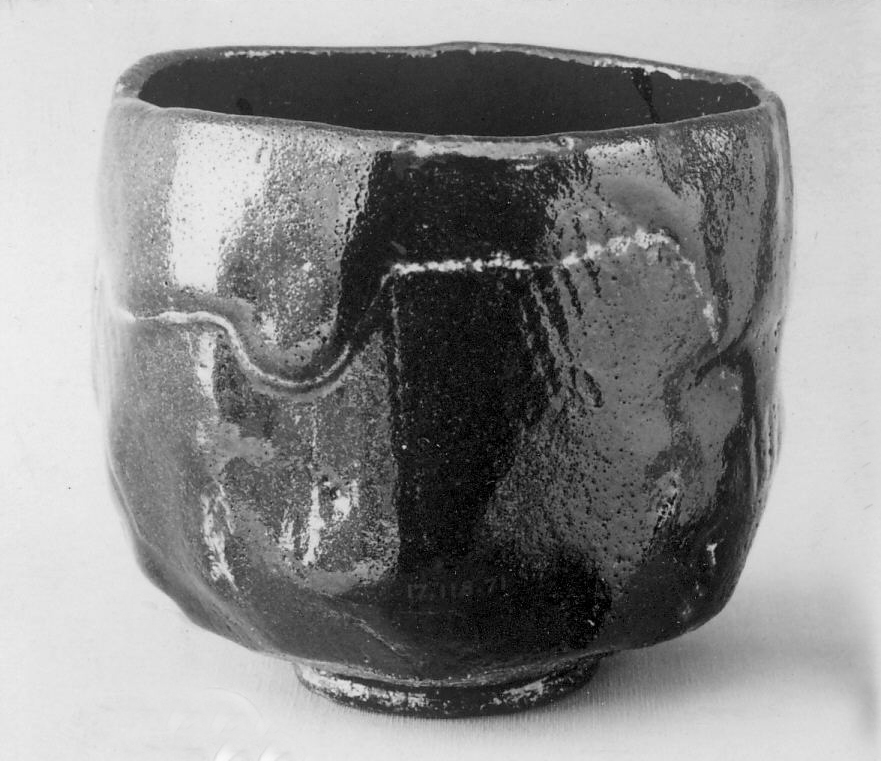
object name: teabowl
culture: japanese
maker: keinyu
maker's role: artist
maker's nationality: japanese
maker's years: 1793-1893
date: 1870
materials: clay, glaze